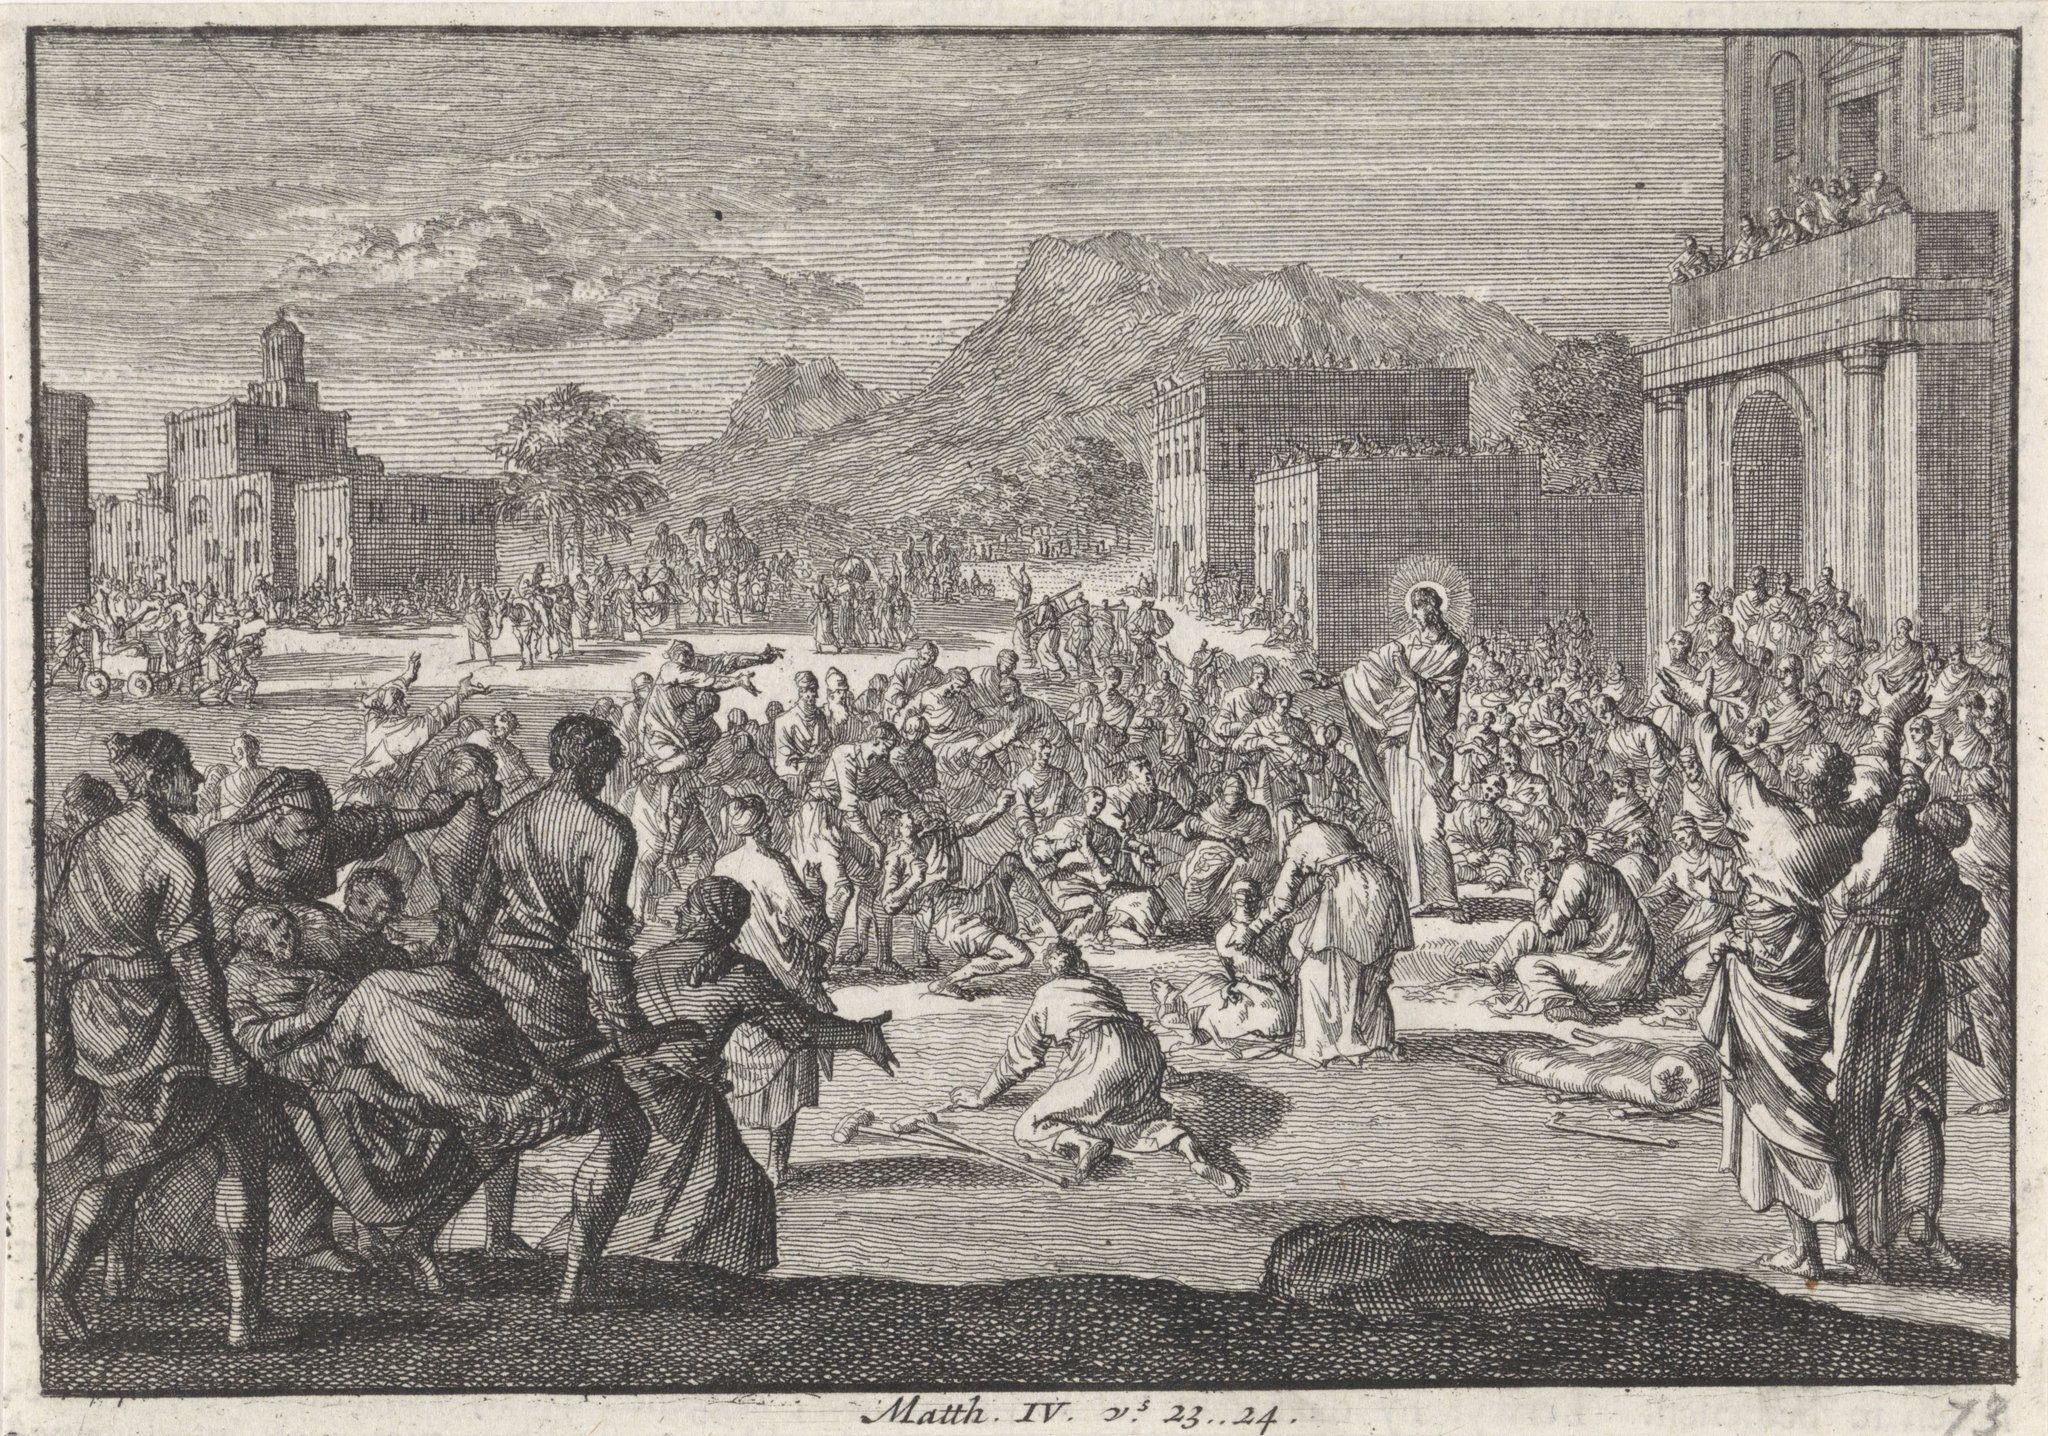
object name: book illustration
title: Christus spreekt tot een menigte op een plein.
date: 1703-1762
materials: paper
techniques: etching, letterpress printing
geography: amsterdam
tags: christ explaining his doctrine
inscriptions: collector's mark: Lugt 2228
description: De prent komt een eerste keer voor als boekillustratie voor David Martin. Historie des Ouden en Nieuwen Testaments. Amsterdam, Pieter Mortier, 1703. Deel II. De boekillustraties voor de Mortierbijbel hebben verschillende staten en kopieën, waarbij de chronologische volgorde moeilijk te achterhalen valt. Als boekillustraties werden ze bovendien herhaaldelijk opnieuw gebruikt voor andere boekwerken.